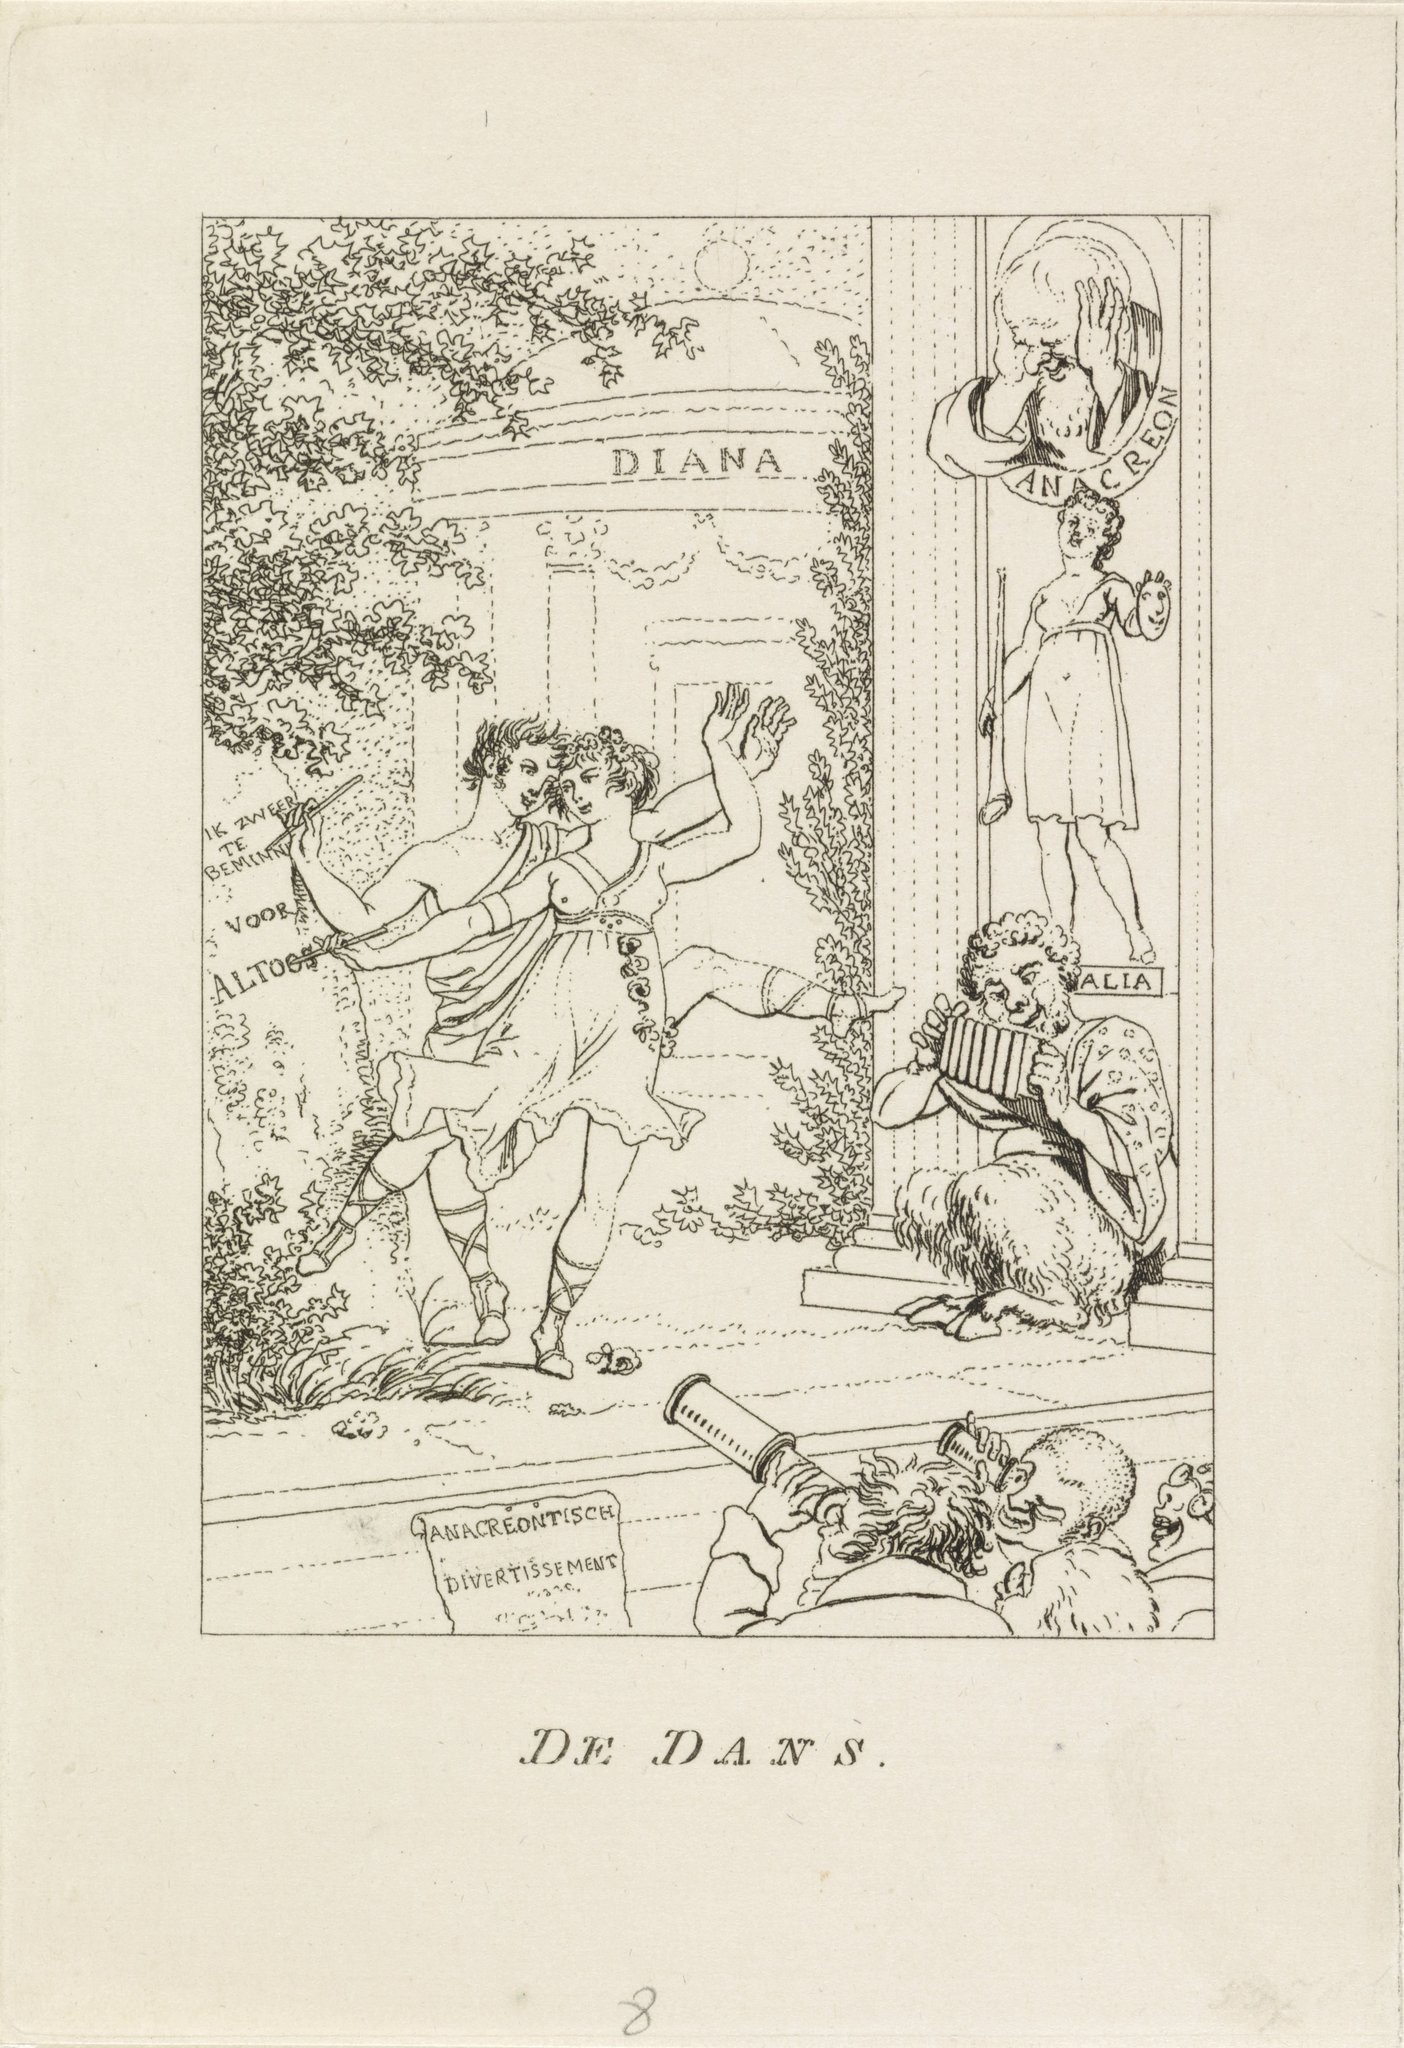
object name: print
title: Toneeldans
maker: jacob ernst marcus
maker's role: draughtsman, print maker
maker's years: 1774-1826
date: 1803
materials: paper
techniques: etching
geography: netherlands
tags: the ballet, ballet performance, one pair dancing; man and woman dancing as a couple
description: Op het toneel dansen een man en vrouw voor een tempel van Diana, sater speelt op de panfluit. Publiek met verrekijker. Achtste prent uit een serie van acht met tot doel de contrasten van het toenmalige werkelijke leven ca. 1800 met de beschaafde wereld (beau-monde) te leveren.